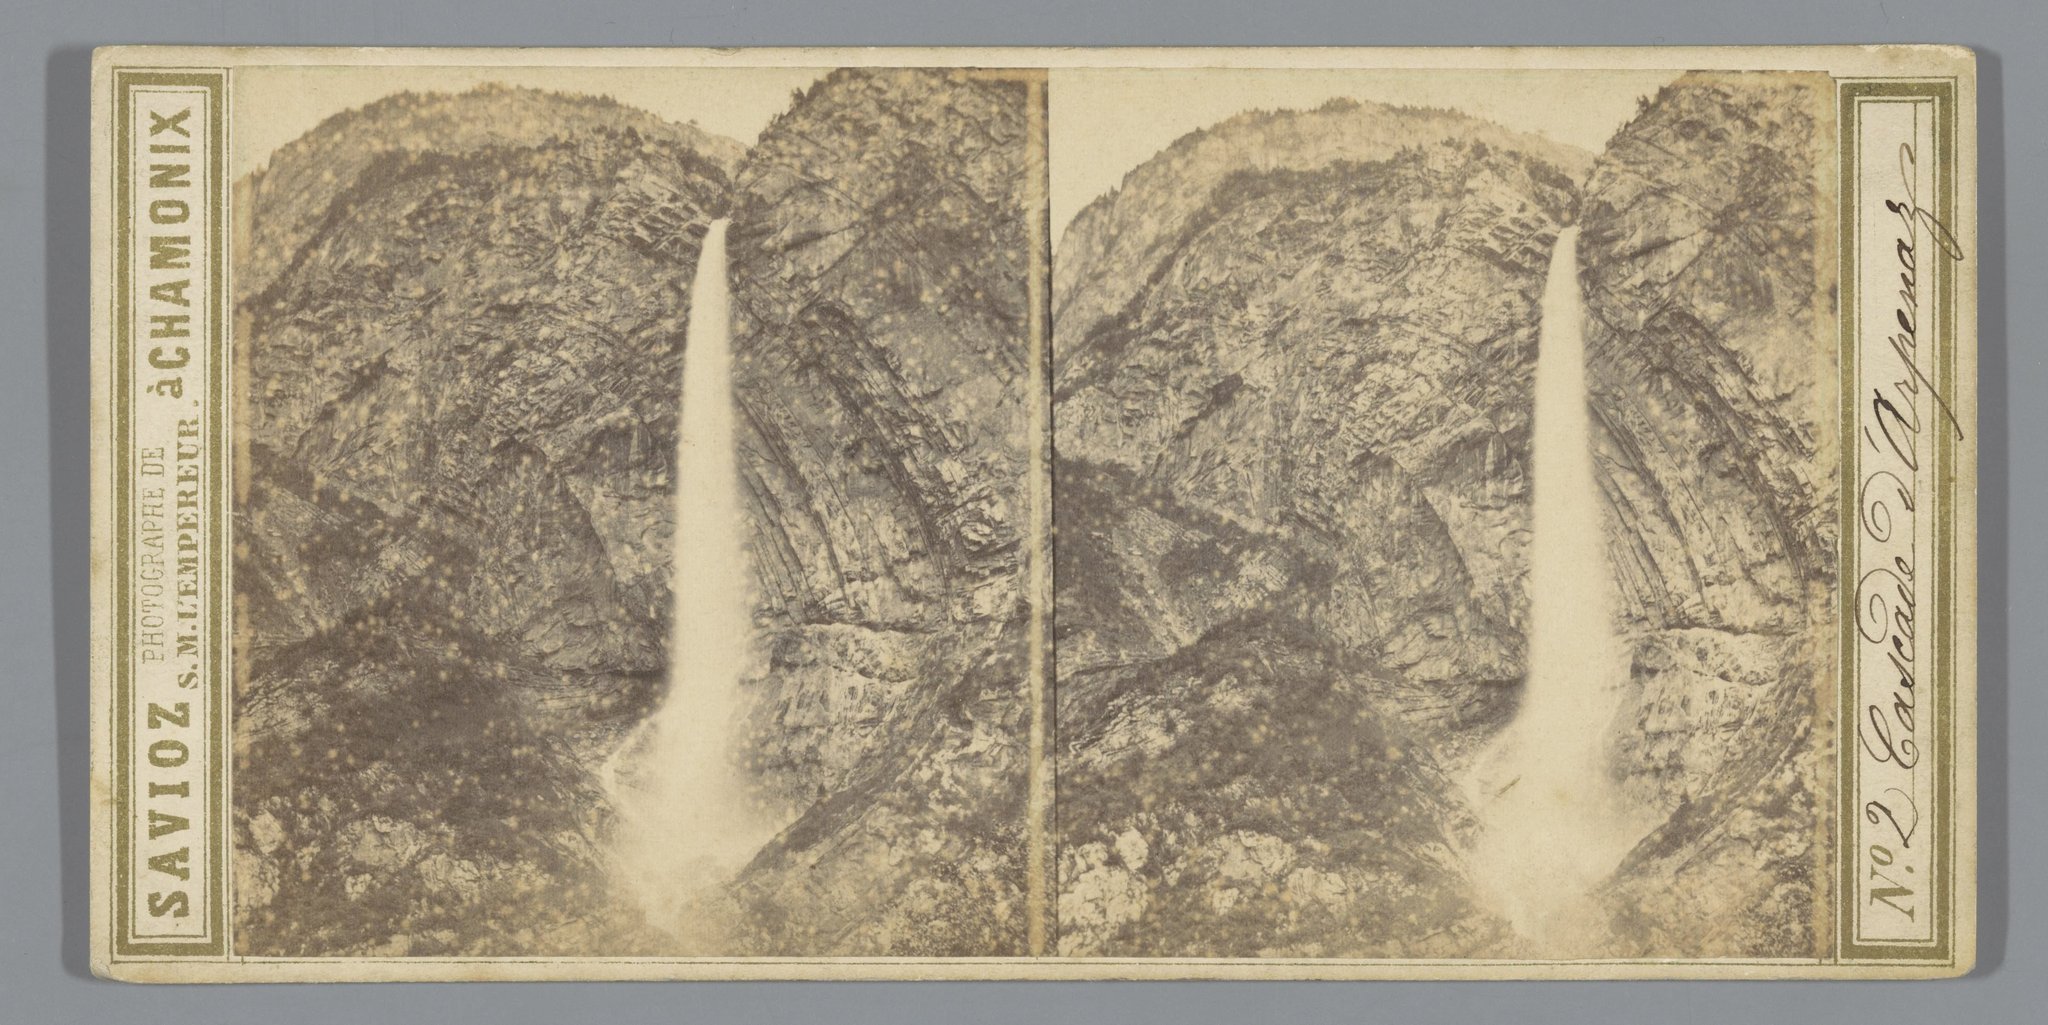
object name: stereograph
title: Waterval van Arpenaz nabij Sallanches, Frankrijk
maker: eugène savioz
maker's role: fotograaf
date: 1867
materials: cardboard, paper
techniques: albumen print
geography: sallanches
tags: waterfall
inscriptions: number: ‘No. 2’